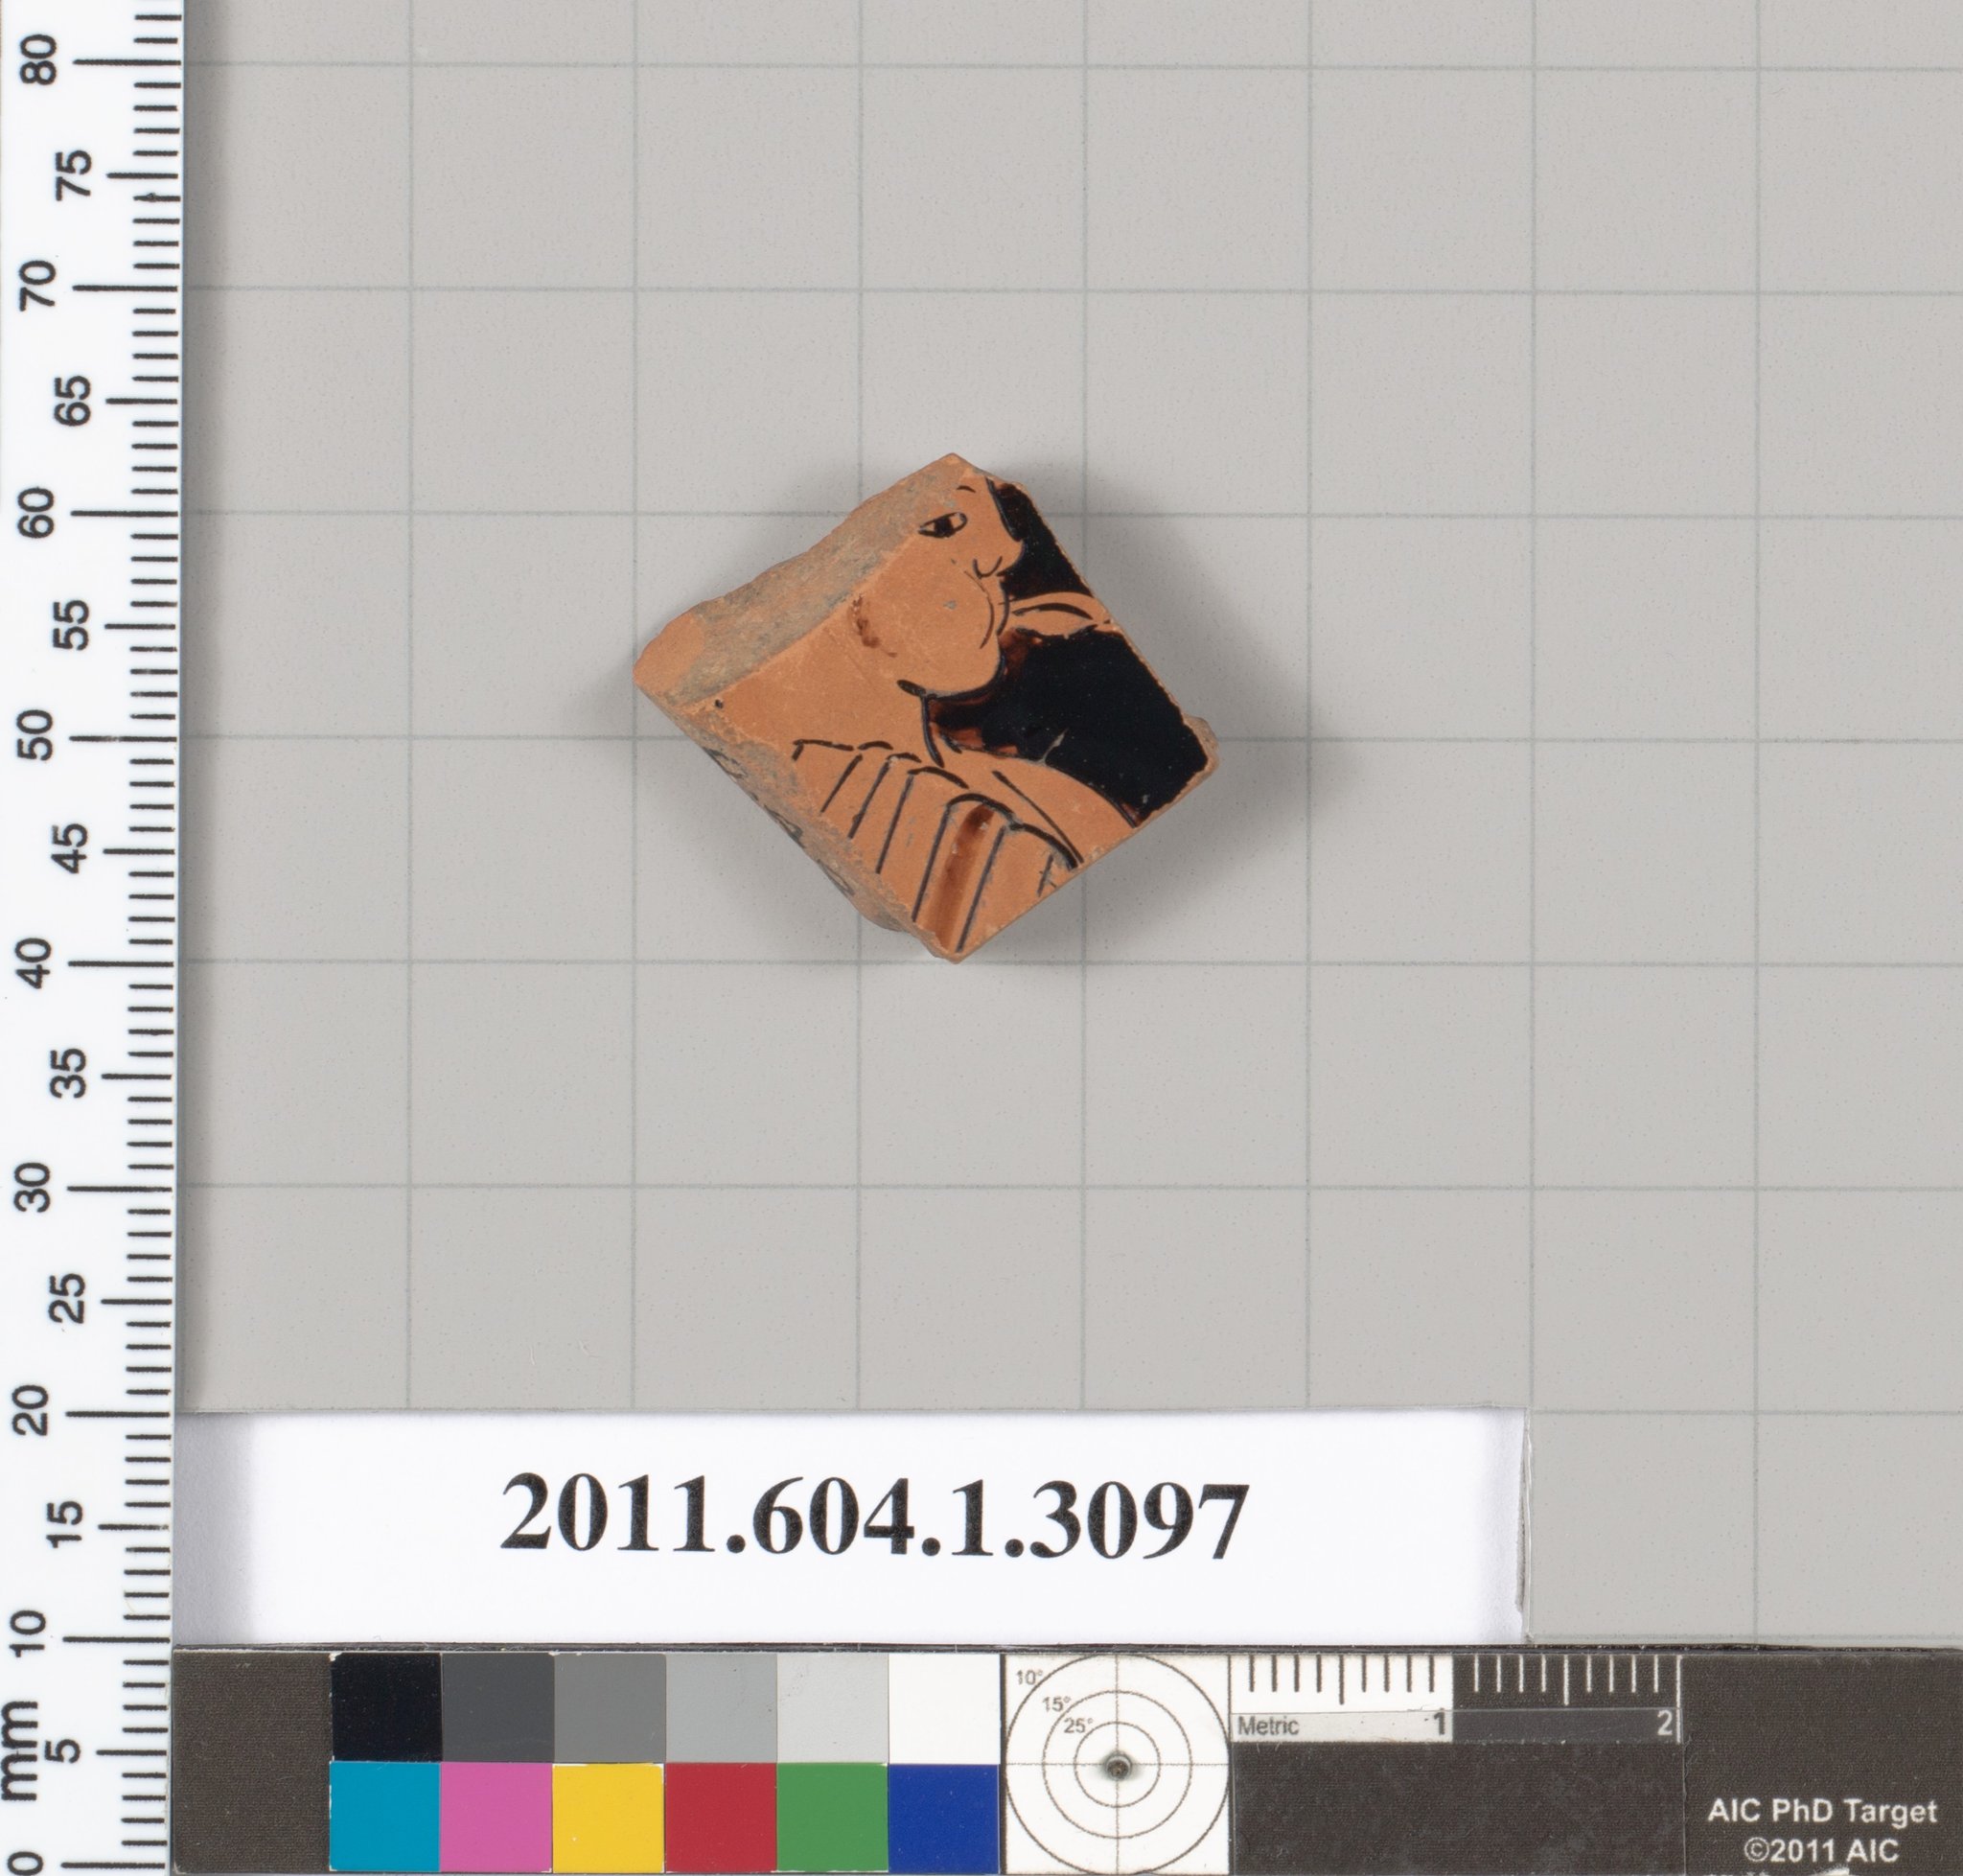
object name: kylix fragment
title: Terracotta fragment of a kylix (drinking cup)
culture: greek, attic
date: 490-480 BCE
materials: terracotta